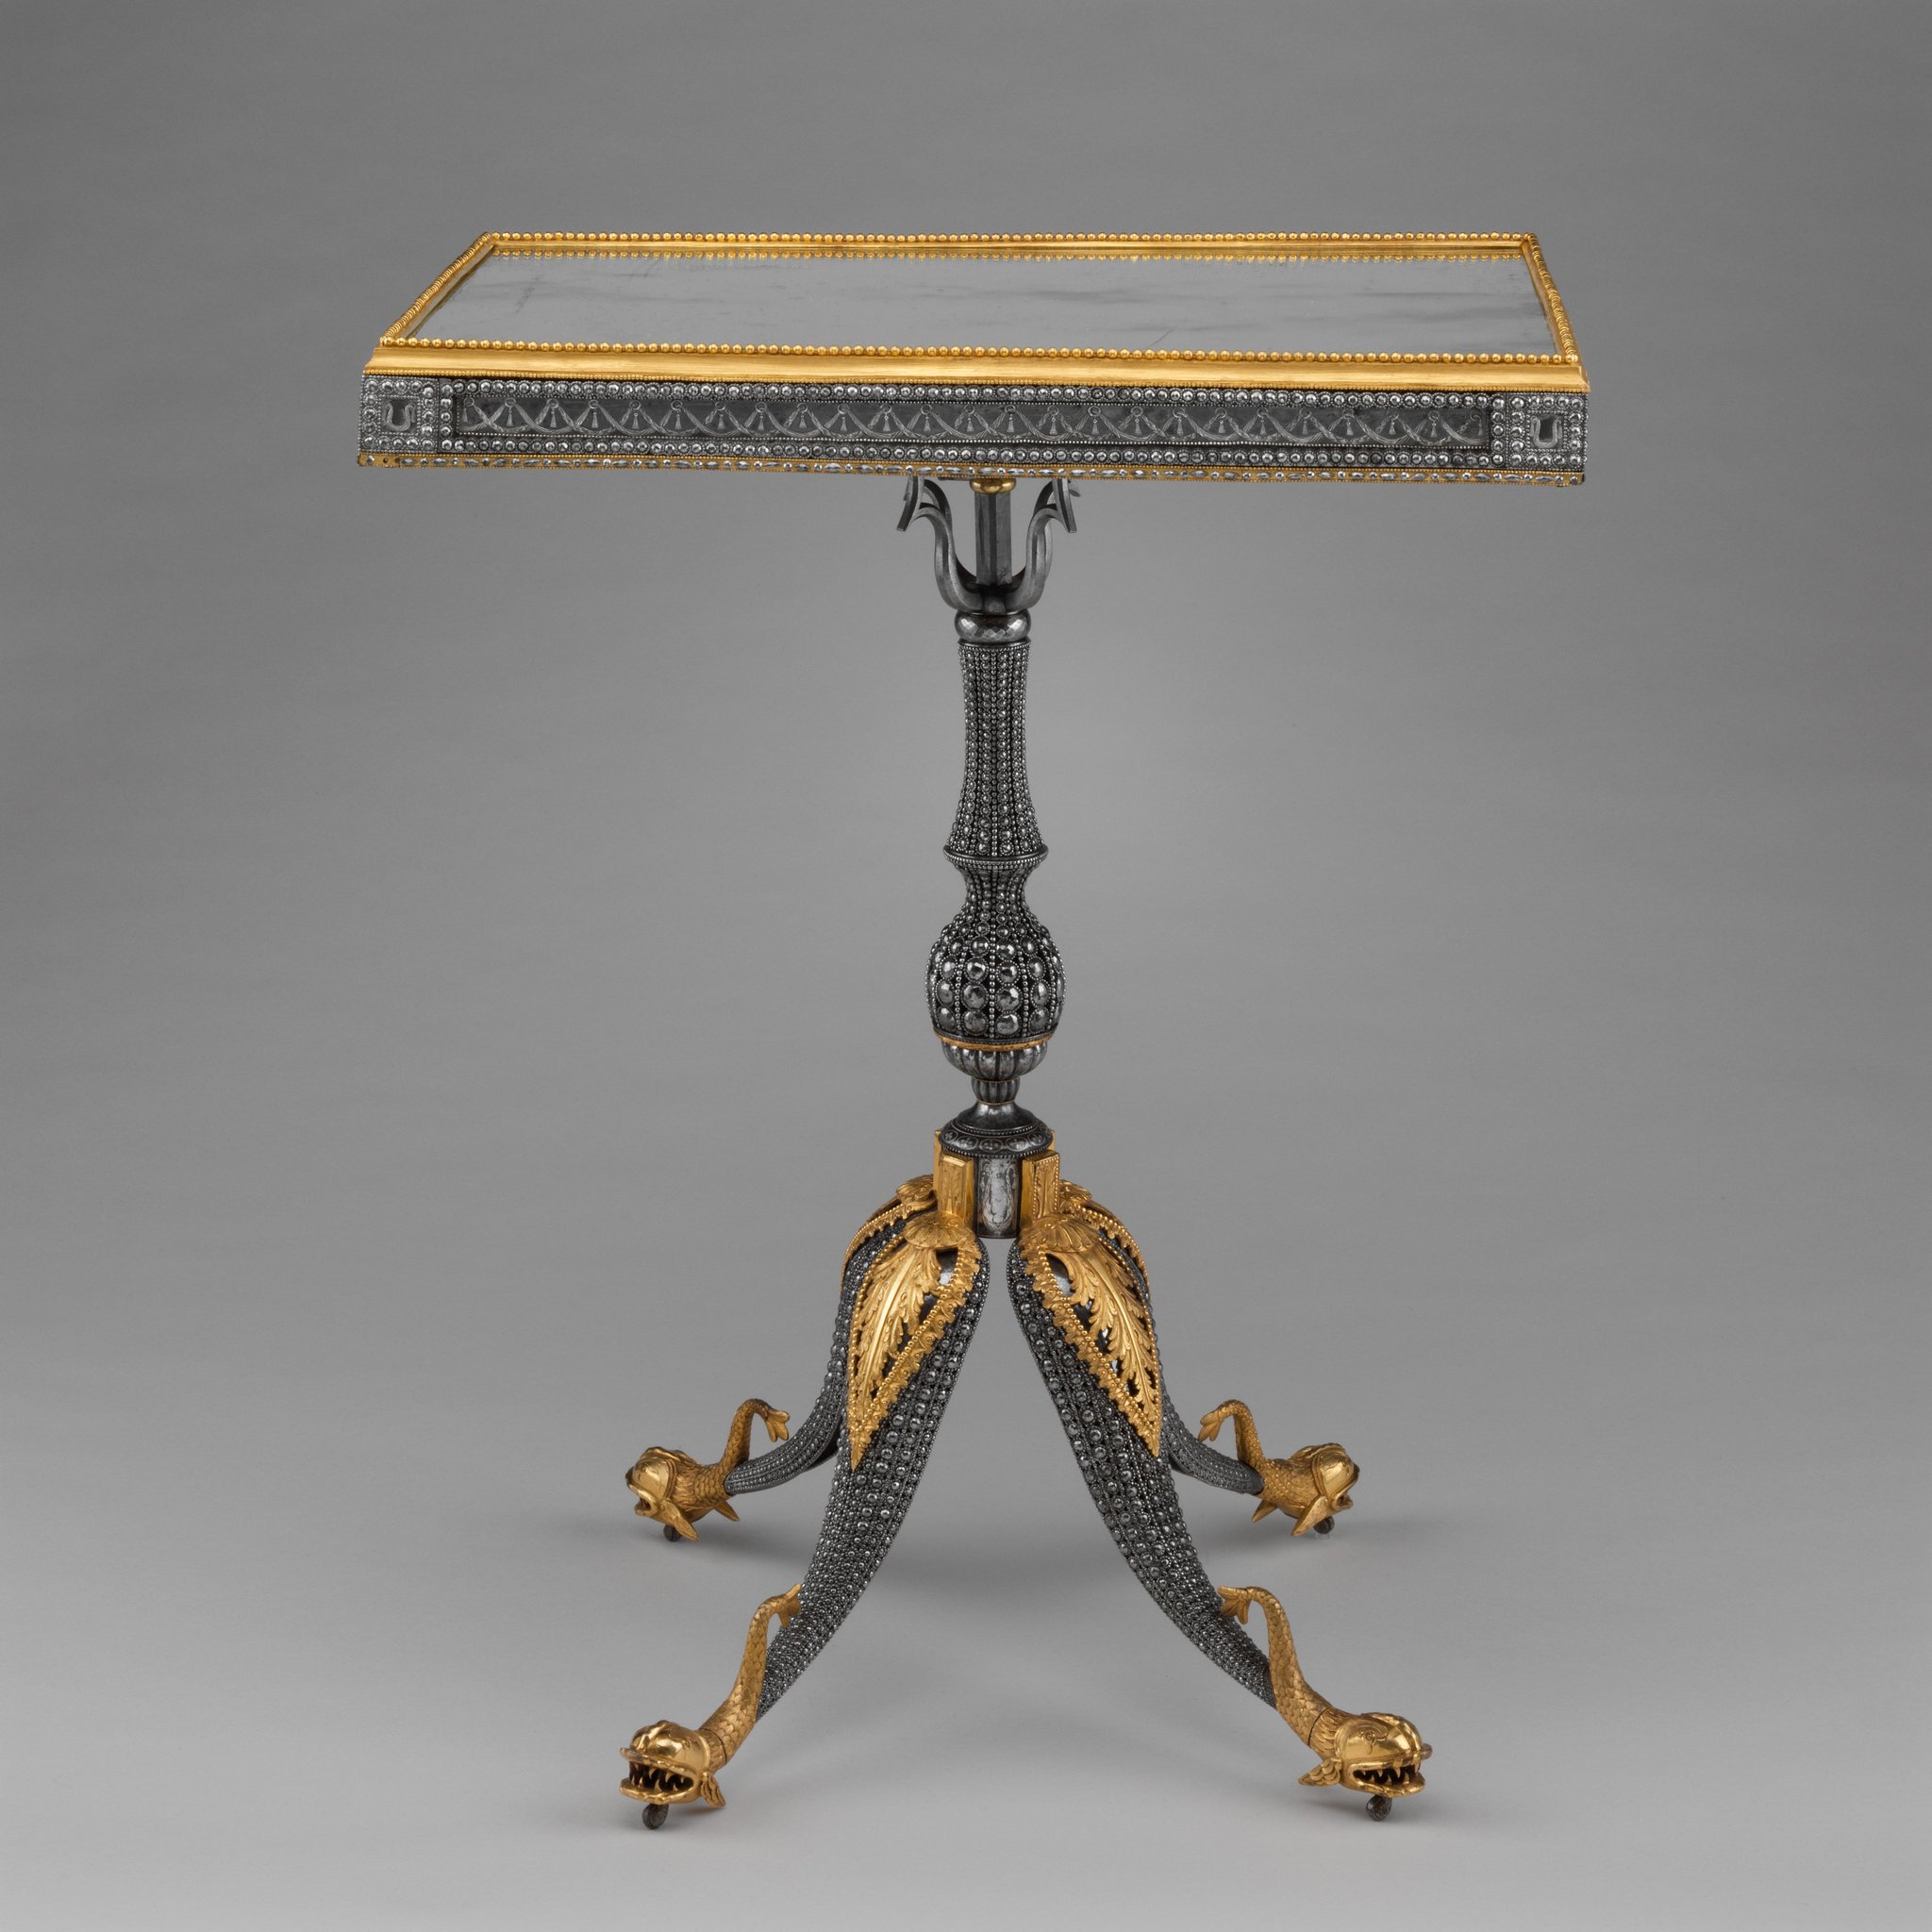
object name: center table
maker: imperial armory, tula (south of moscow), russia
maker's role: manufacturer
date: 1780-1785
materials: brass, gilt, copper gilt, glass, silver, steel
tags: dolphins